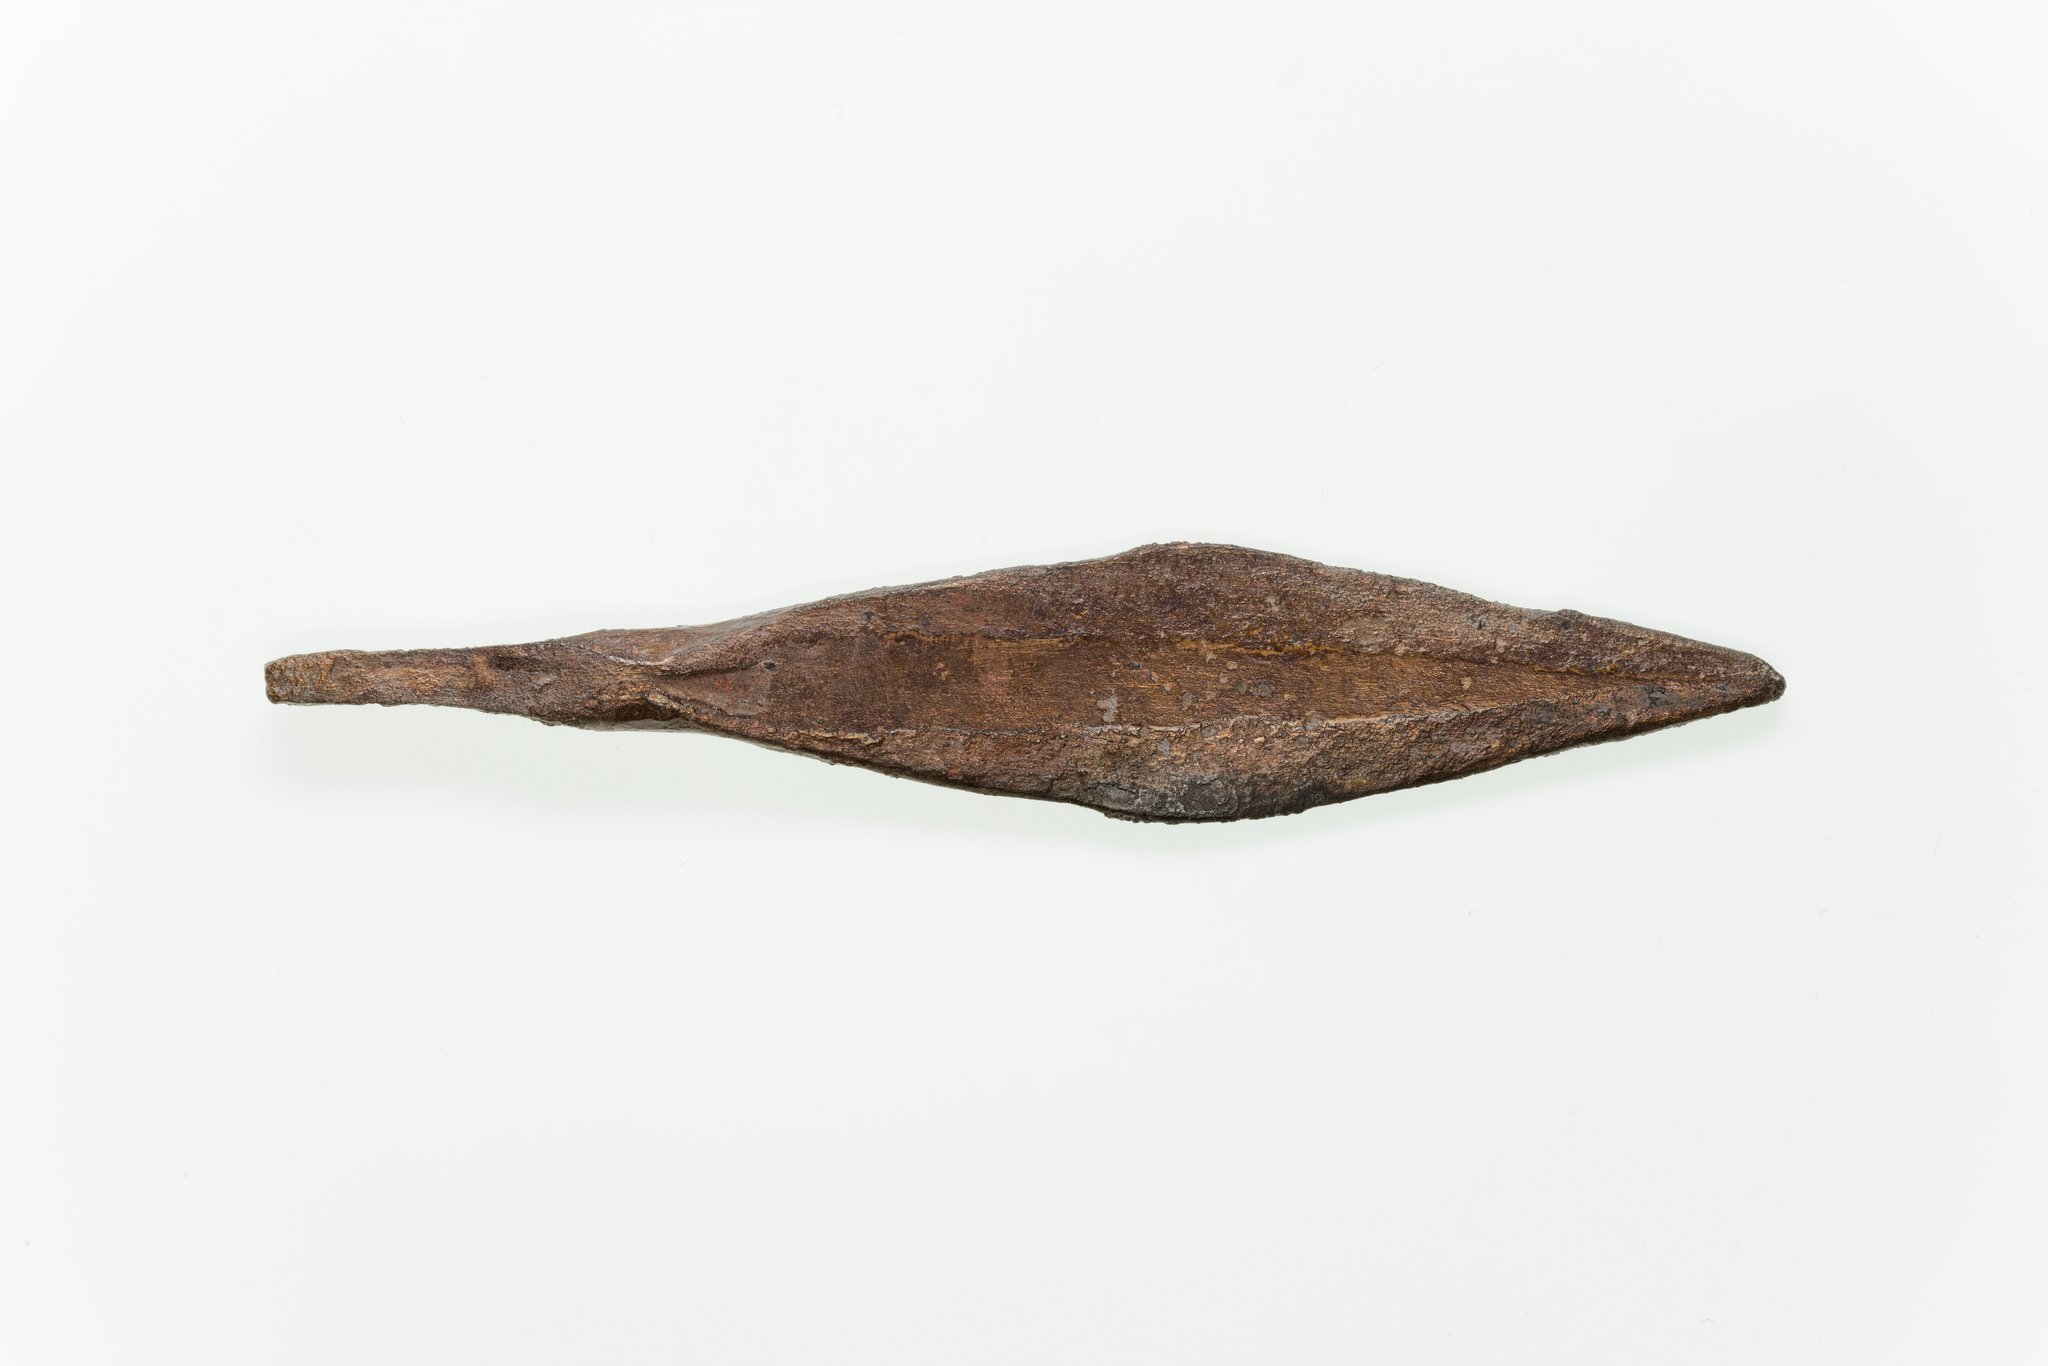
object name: arrow point, neferkhawet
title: Arrow or Javelin Point of Neferkhawet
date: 1504-1447 BCE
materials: bronze, copper alloy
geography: egypt